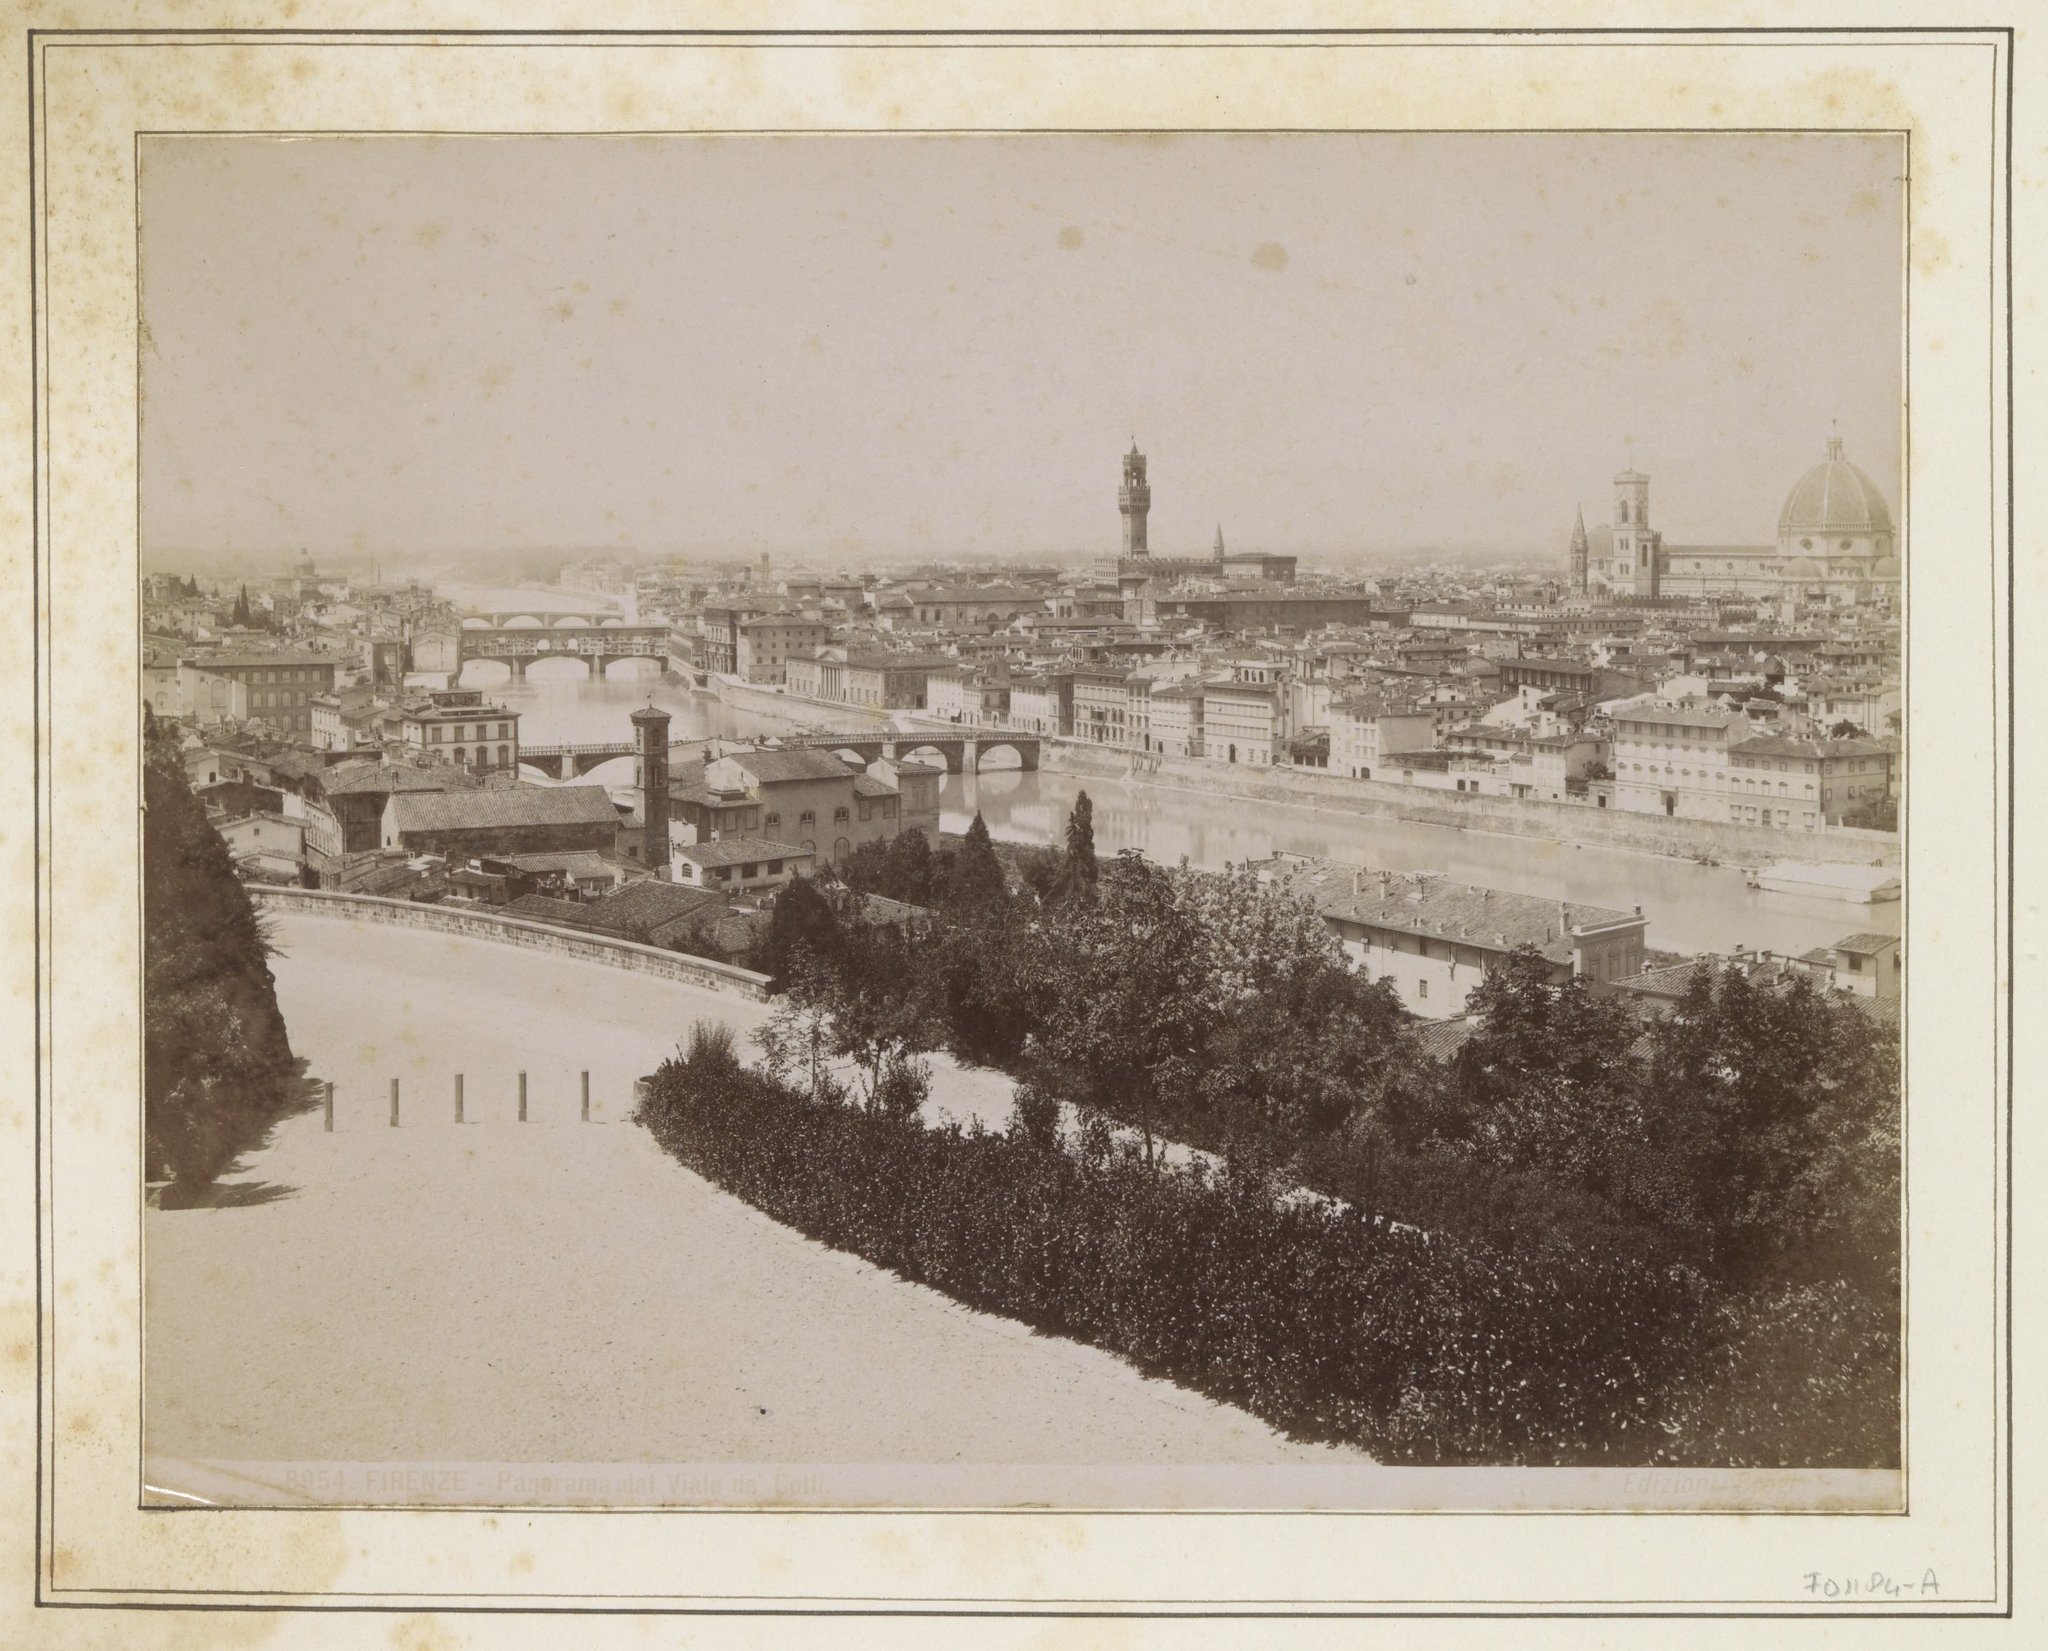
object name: photograph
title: Gezicht op Florence vanaf de Viale de Celli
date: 1865-1890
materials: paper, photographic support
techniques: albumen print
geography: florence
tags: river (+ landscape with figures, staffage), prospect of city, town panorama, silhouette of city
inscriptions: negative number: ‘8954’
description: Onderdeel van Reisalbum met foto's van bezienswaardigheden in Italië (deel I).